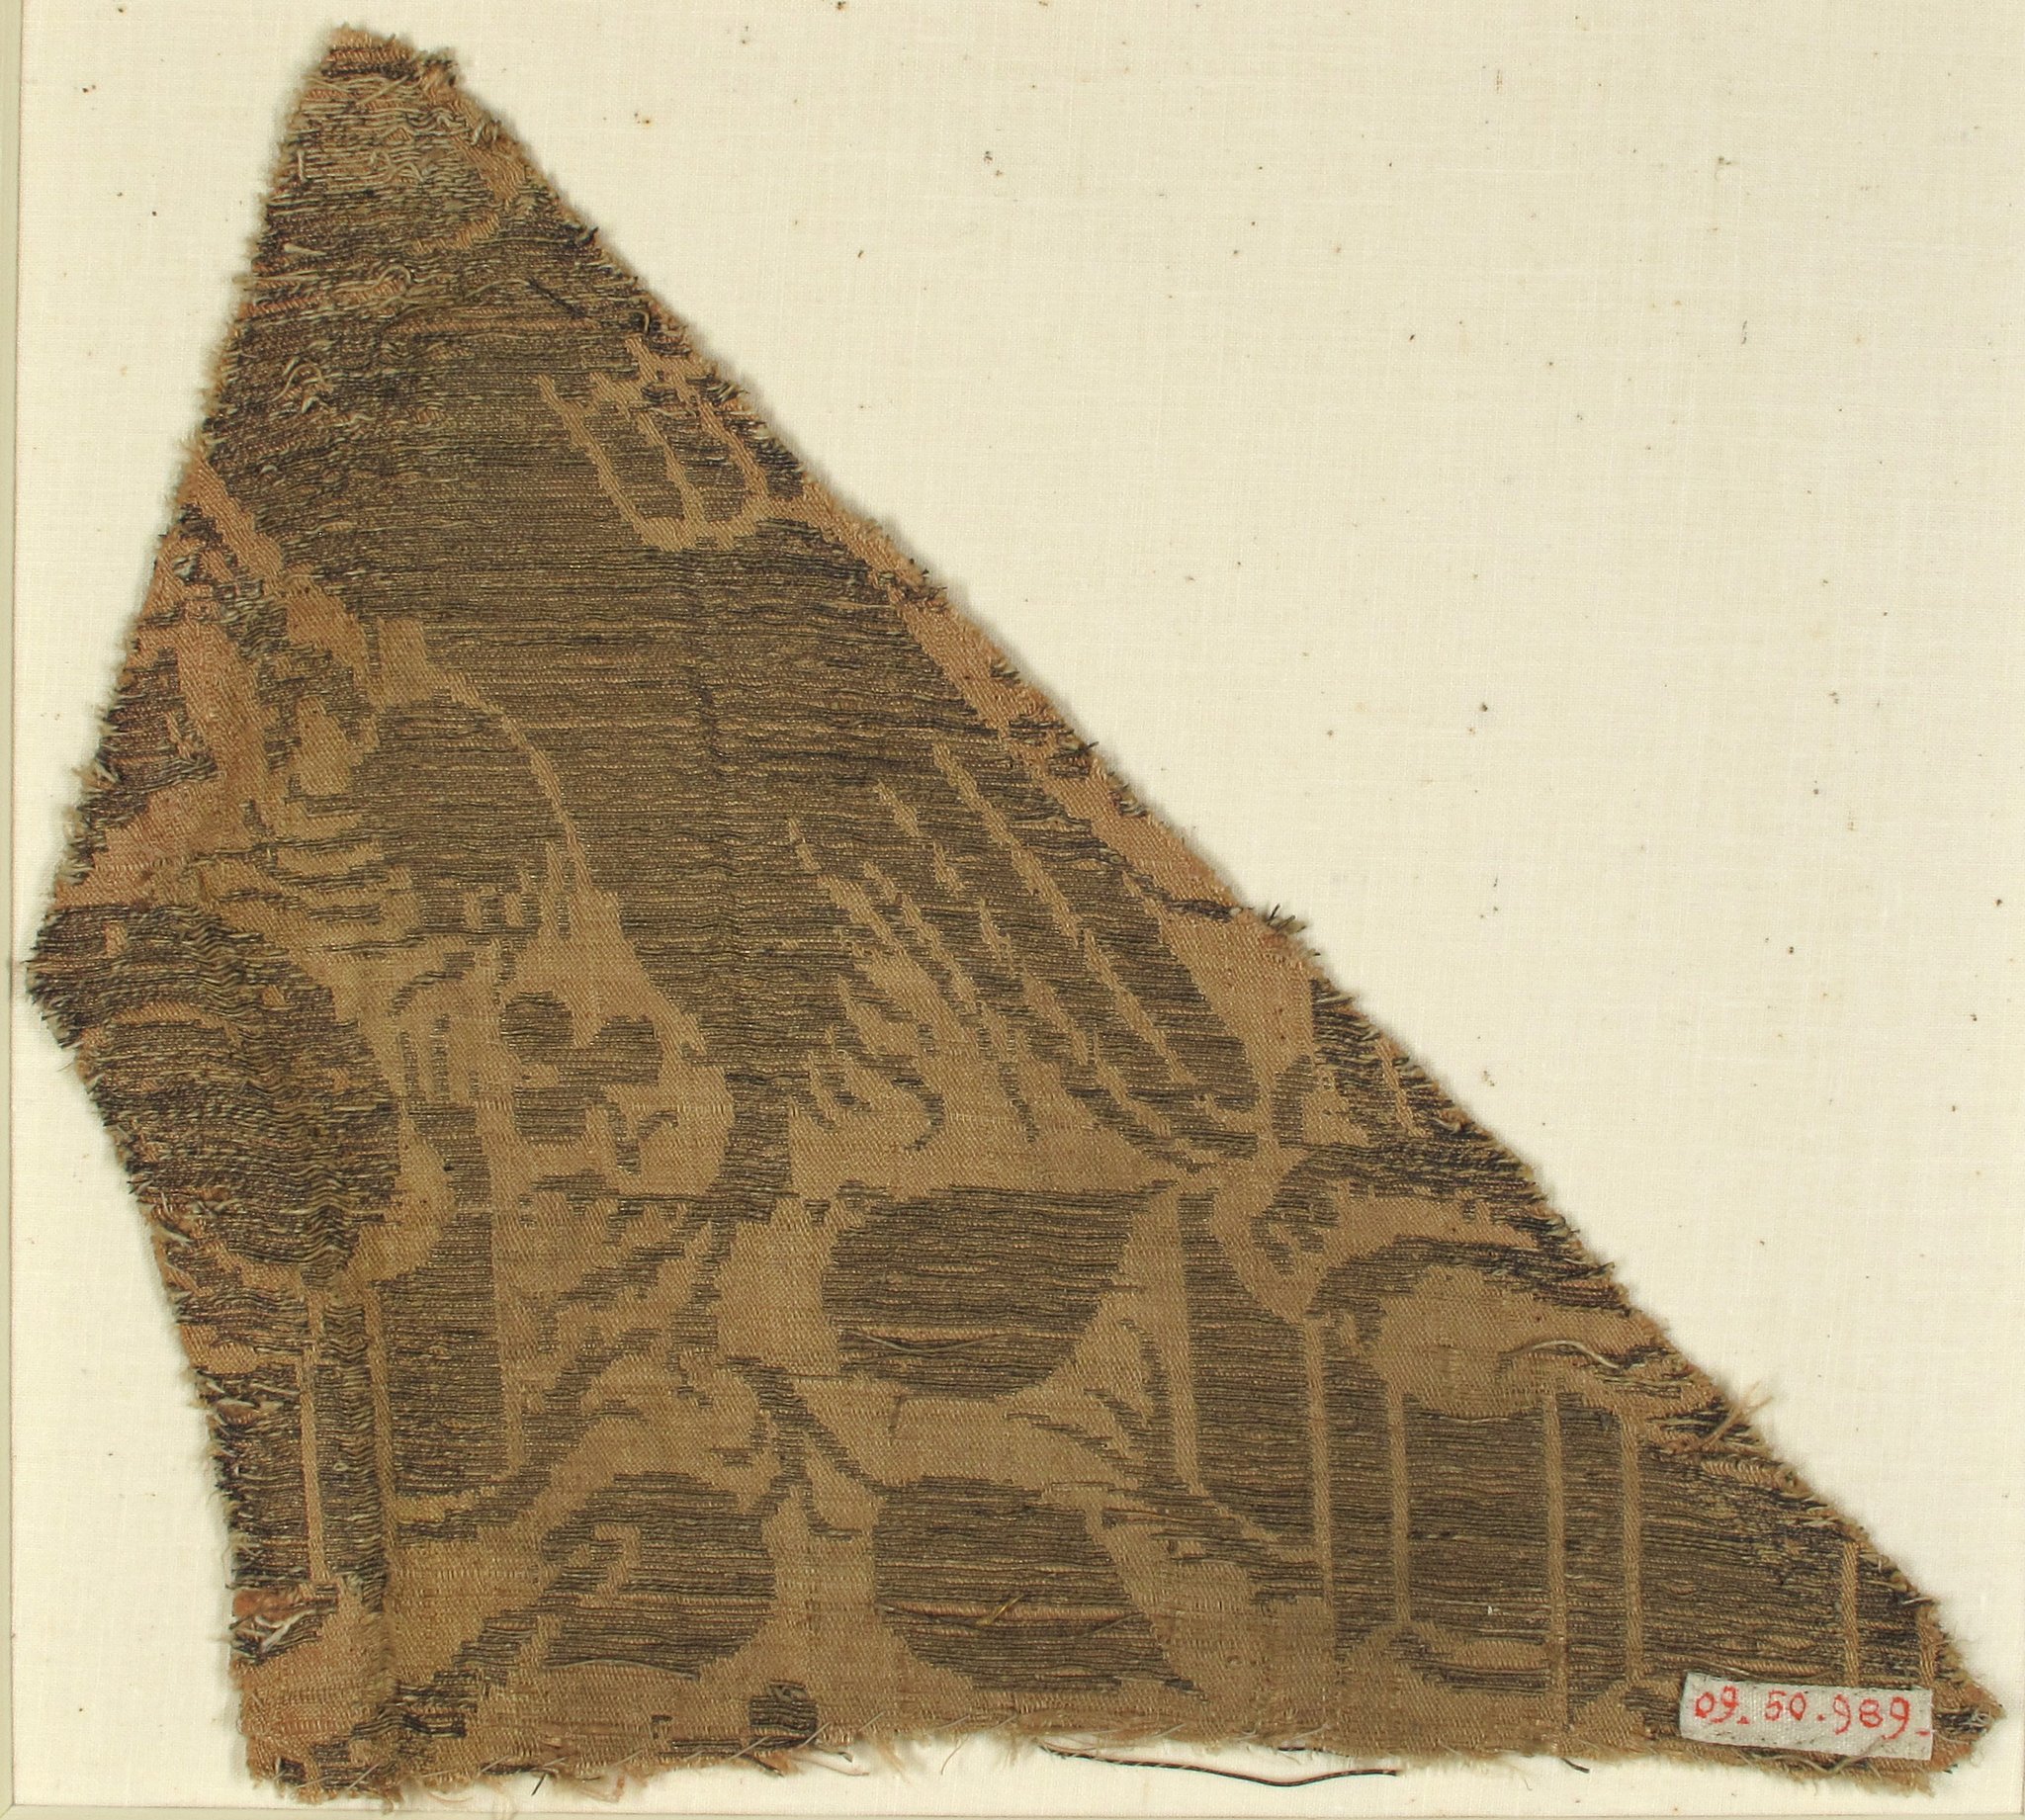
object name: textile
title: Textile with Eagle Attacking Dog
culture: italian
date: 1401-1500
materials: gold thread, silk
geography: italy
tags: eagles